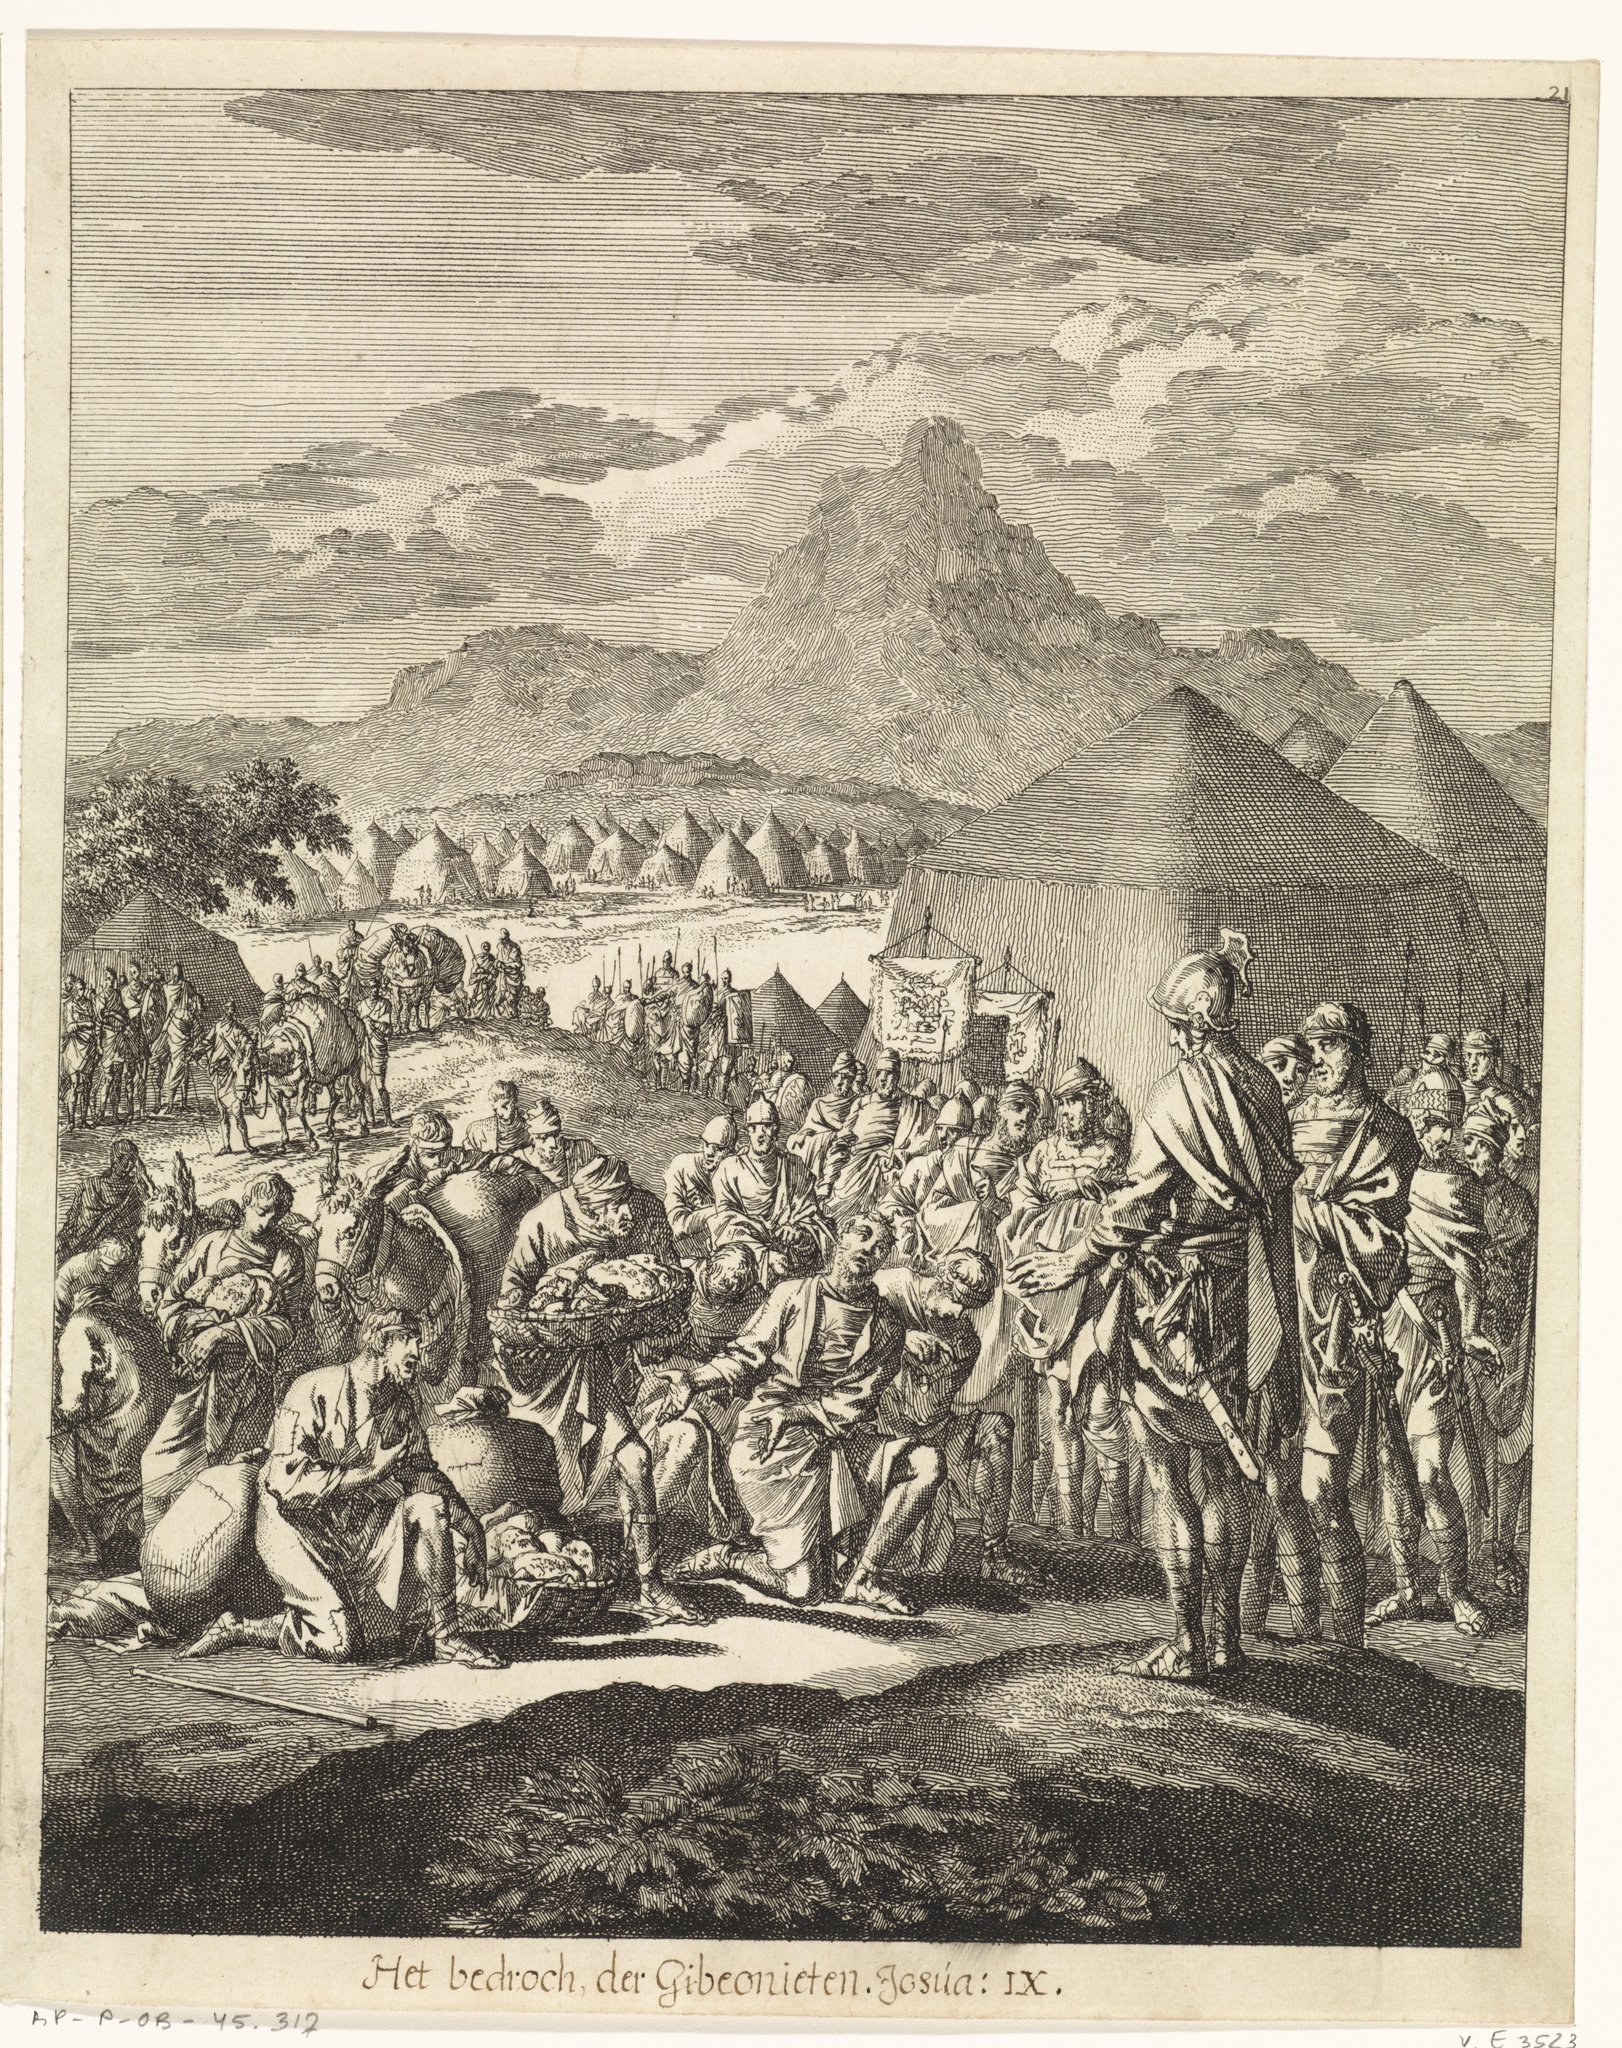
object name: print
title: Jozua ontvangt de Gibeonieten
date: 1708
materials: paper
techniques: etching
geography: amsterdam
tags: the ruse of the gibeonites (joshua 9)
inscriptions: collector's mark: Lugt 2228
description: Proefdruk van een prent welke is opgenomen als illustratie in: Historiae Celebriores Veteris Testamenti. Christoph Weigel, 1708.